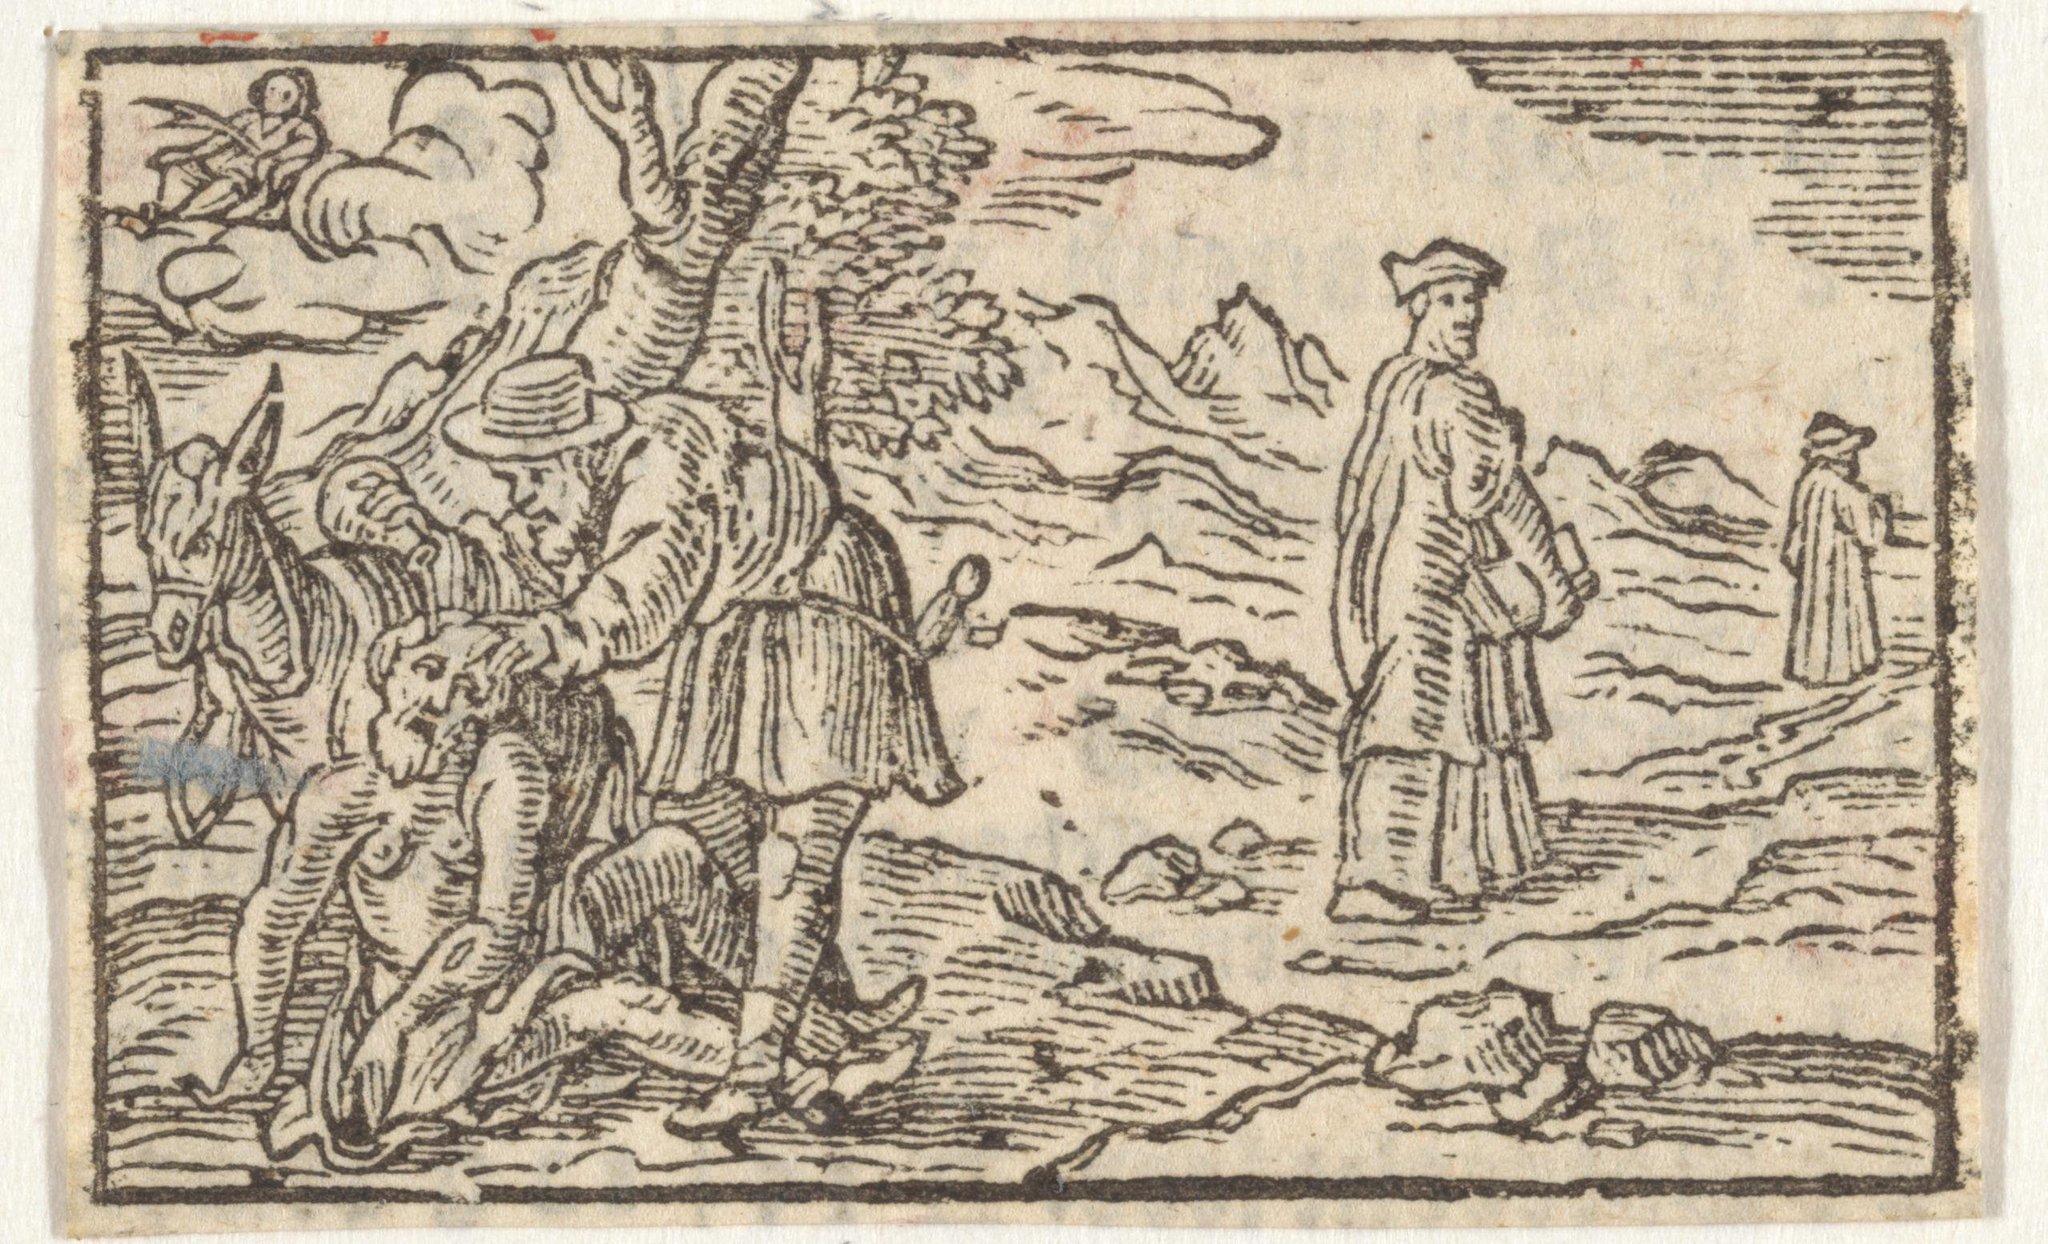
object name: print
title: Augustus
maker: Anonymous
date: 1600-1699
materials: paper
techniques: letterpress printing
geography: netherlands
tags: a priest and/or a levite passing by without attending to the wounded man ~ parable of the good samaritan, a samaritan tending the wounds of the traveller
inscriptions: collector's mark: Lugt 240